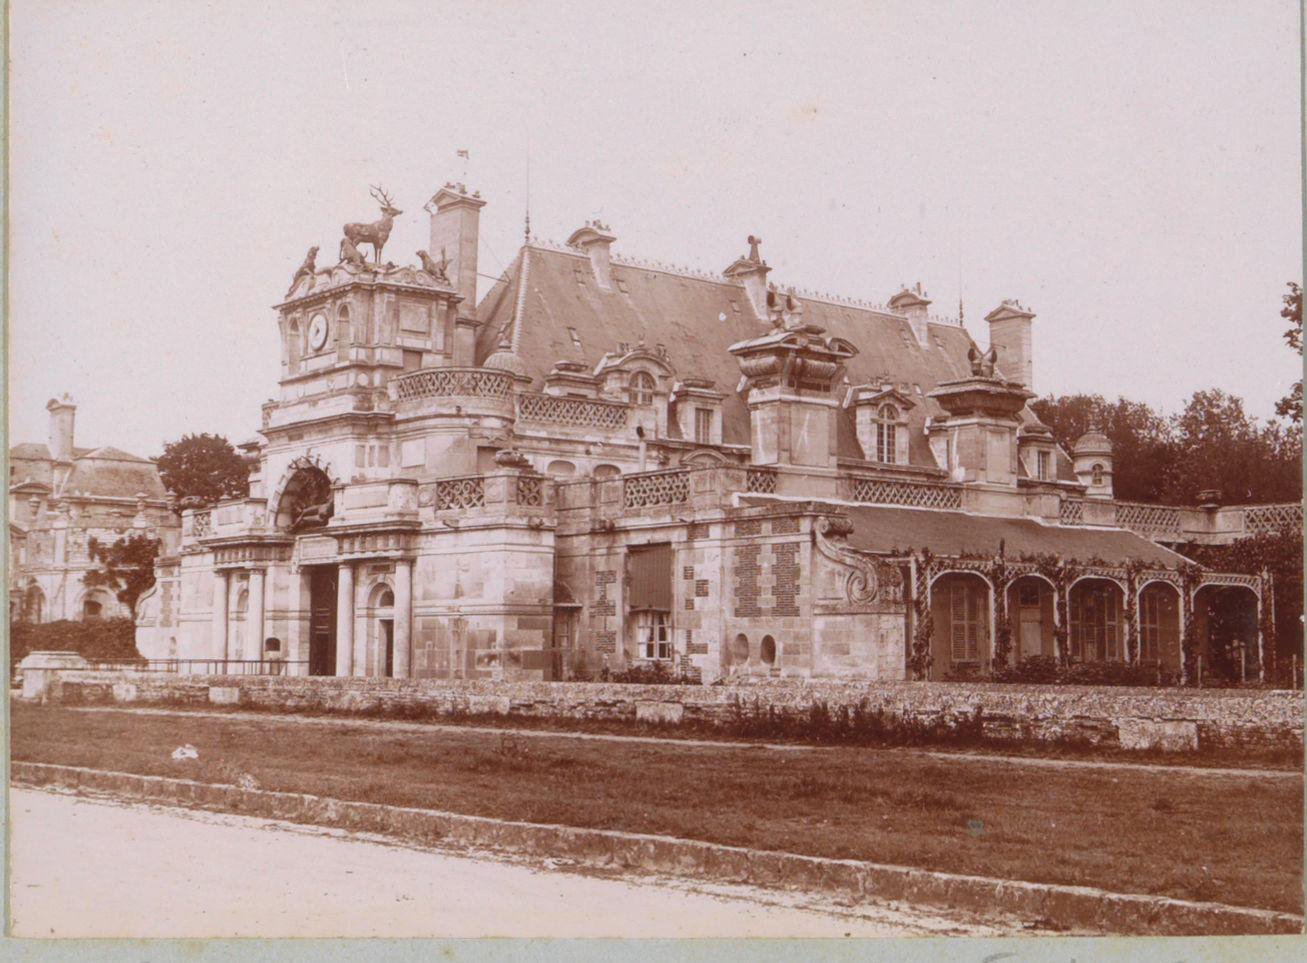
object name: photograph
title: Exterieur van het Château d'Anet in Dreux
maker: delizy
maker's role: manufacturer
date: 1896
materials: paper, photographic support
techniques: gelatin silver print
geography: dreux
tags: castle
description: Onderdeel van Fotoalbum van een Franse amateurfotograaf met opnames van uitstapjes in Frankrijk, Spanje, België, Luxemburg en Nederland, de eerste automobielen en autoraces.